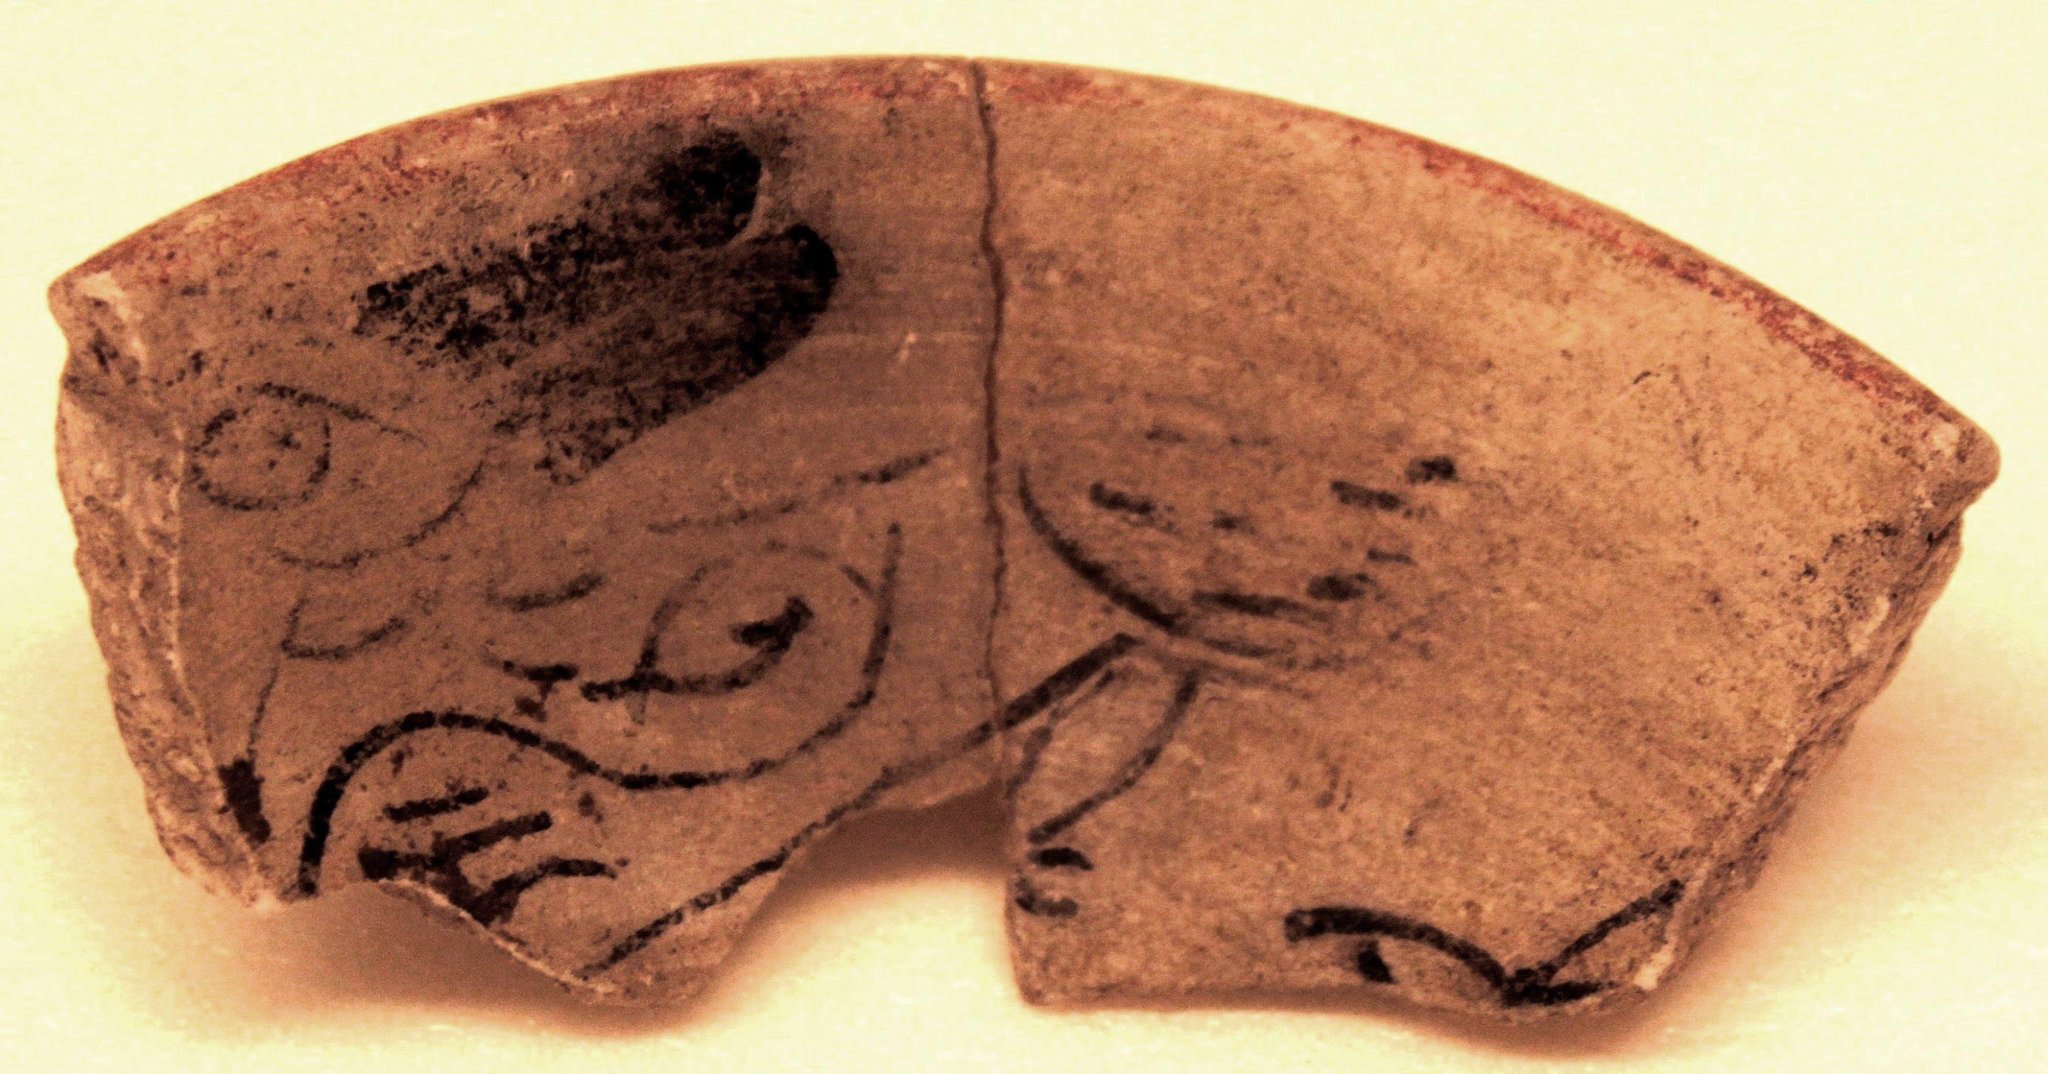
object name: fragment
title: Fragment of a Bowl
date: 801-1000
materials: alabaster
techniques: carving, painting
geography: nishapur